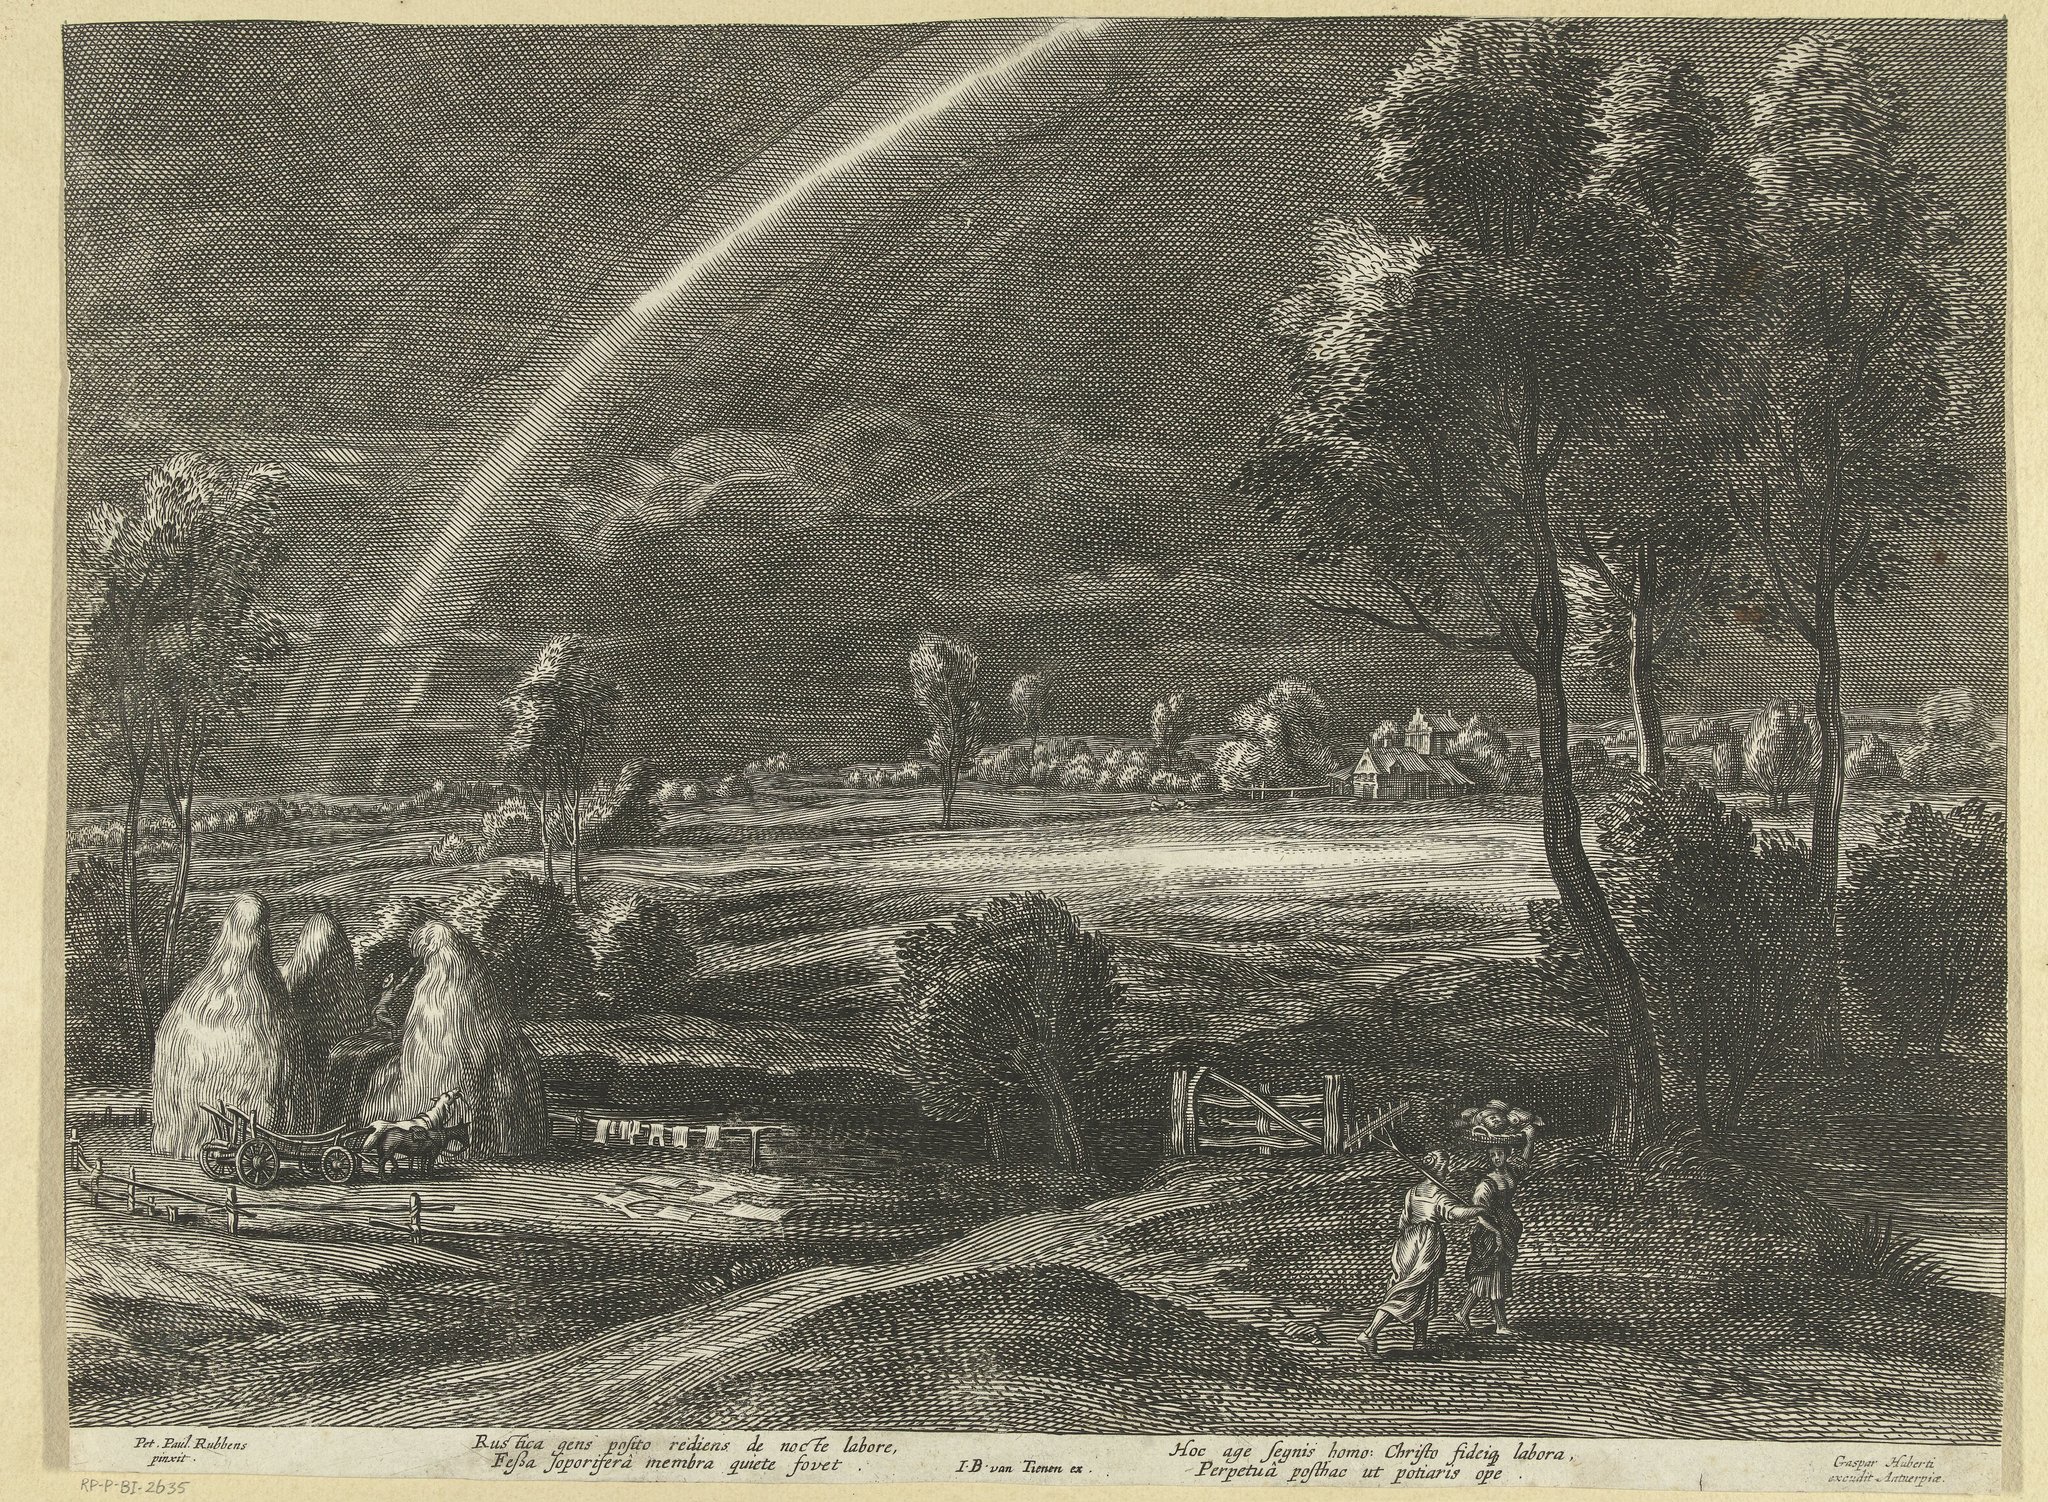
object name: print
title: Landschap met regenboog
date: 1596-1709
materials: paper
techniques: engraving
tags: full moon, meadow, pasture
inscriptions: collector's mark: Lugt 240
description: Kopie in spiegelbeeld naar prent van S.A. Bolswert. Bolswert vervaardigde zijn prent naar een schilderij van Peter Paul Rubens. Hollstein beschrijft een serie kleine landschappen onder de nrs. 305 t/m 325 maar deze prenten zijn niet als reeks vervaardigd.